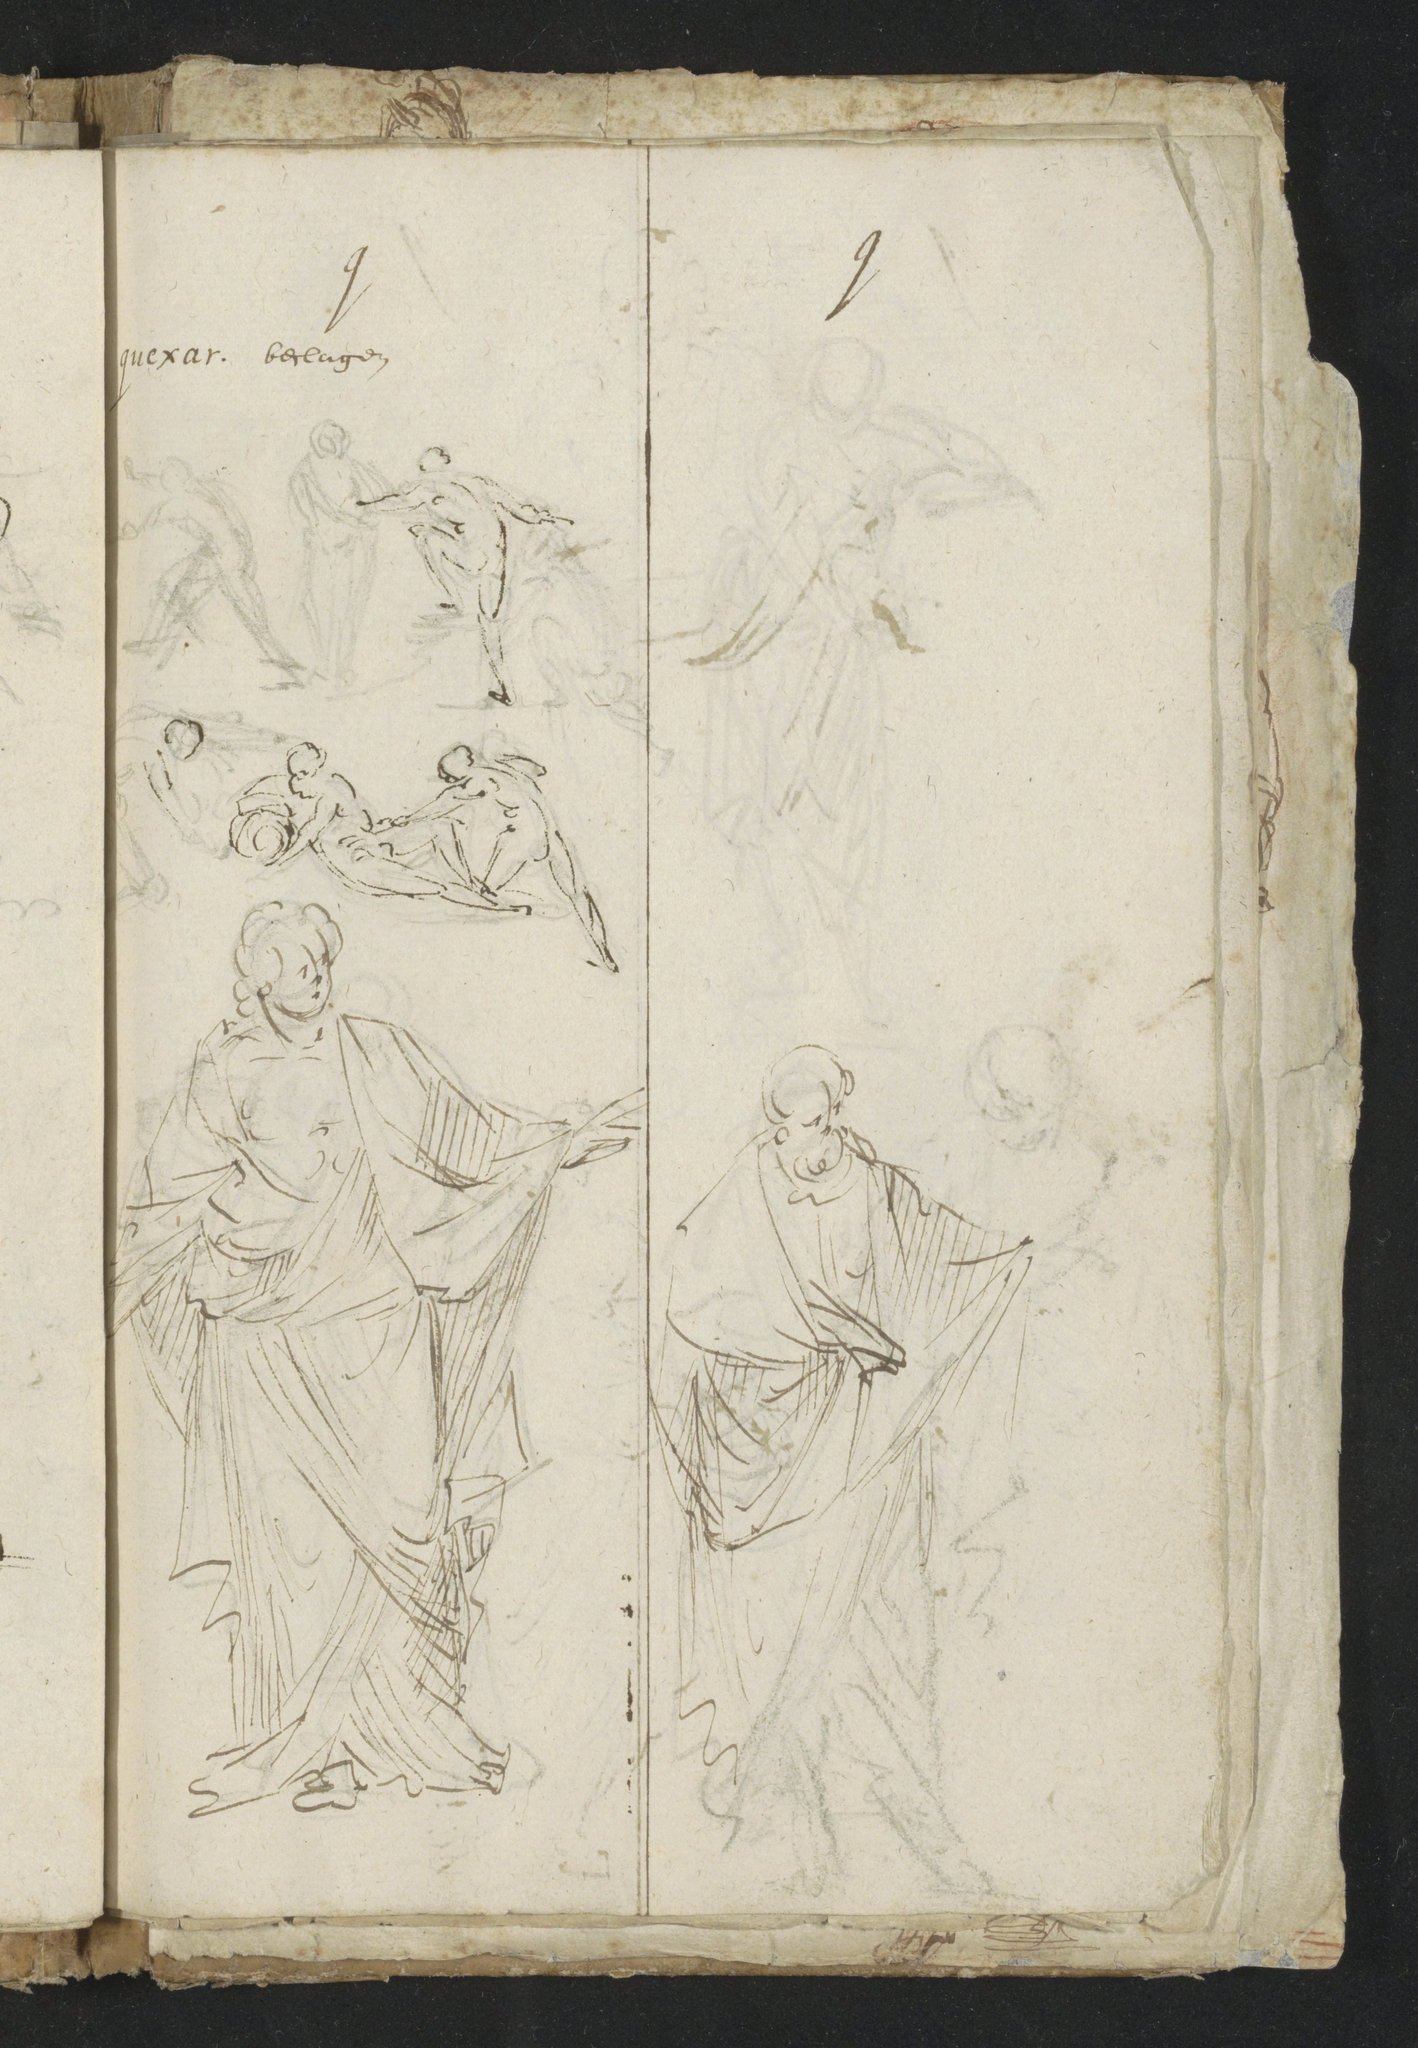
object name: sketchbook leaf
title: Studieblad met mannen in toga en een riviergod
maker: Anonymous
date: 1658-1728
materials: chalk, ink, paper, pencil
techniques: pen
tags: standing figure, river-gods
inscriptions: annotation: ‘q q/ quexar [...]’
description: De riviergod ligt en leunt met een arm op een kruik. Blad 30 recto uit een schetsboek met 33 bladen.